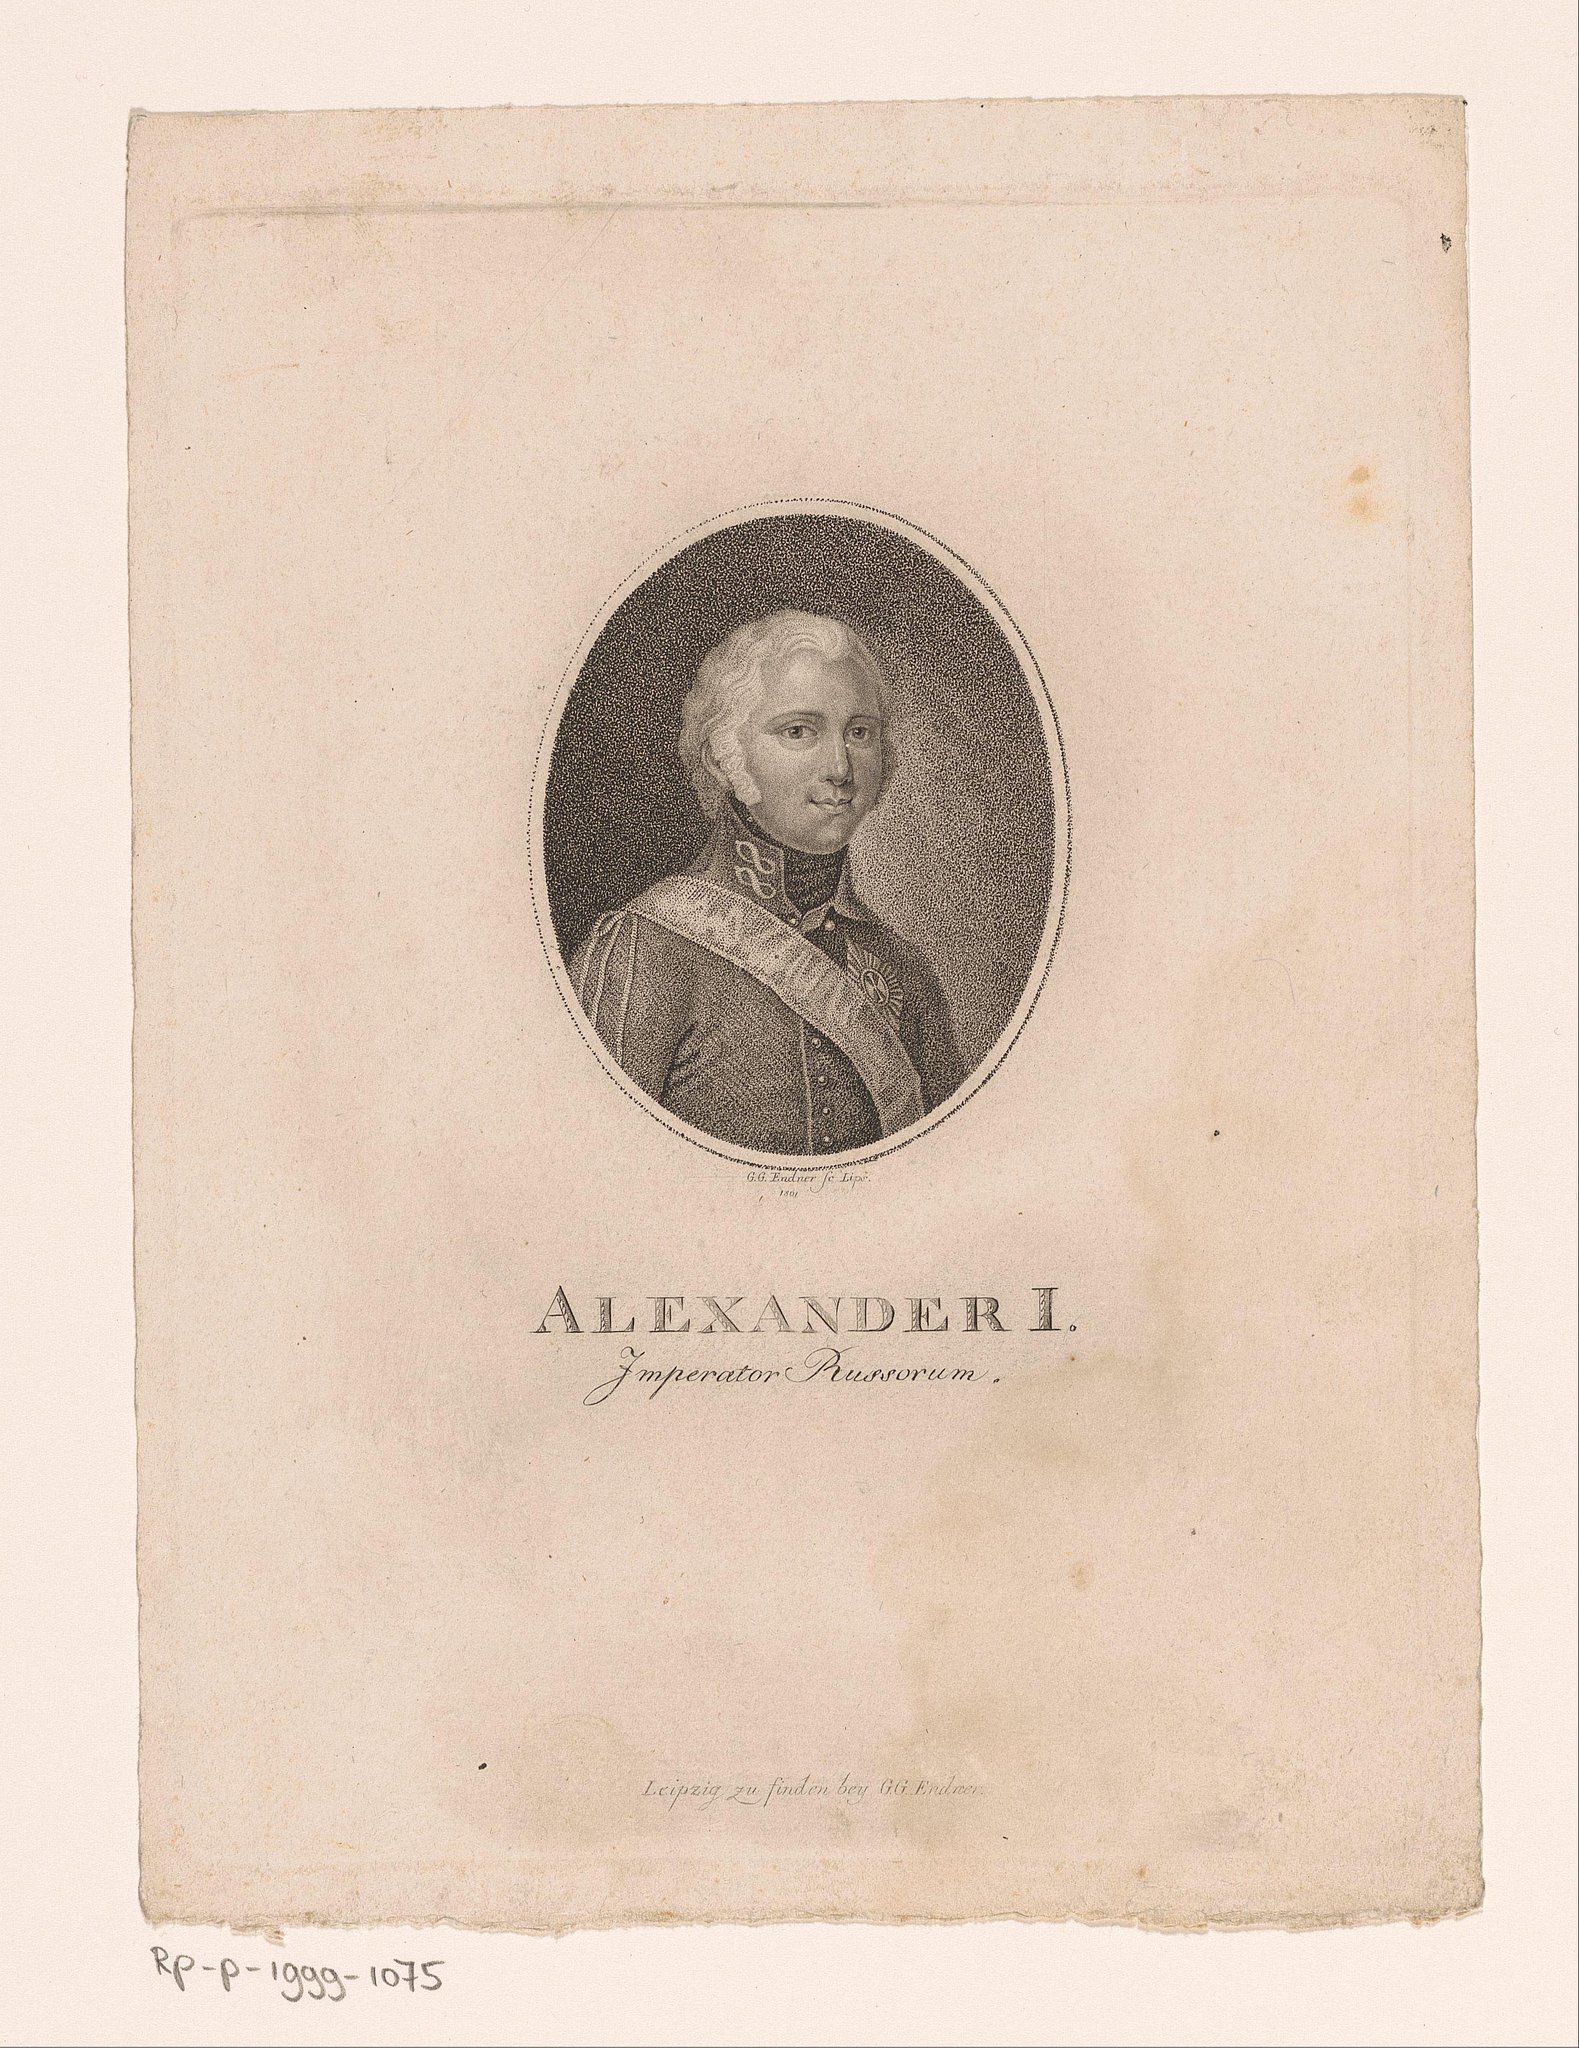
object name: print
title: Portret van Alexander I, tsaar van Rusland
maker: gustav georg endner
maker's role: print maker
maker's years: 1754-1824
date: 1801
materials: paper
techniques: stippling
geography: leipzig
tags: alexander i (tsaar van rusland), knighthood order, historical persons, ruler, sovereign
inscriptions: collector's mark: Lugt 2228, collector's mark: Lugt 2760